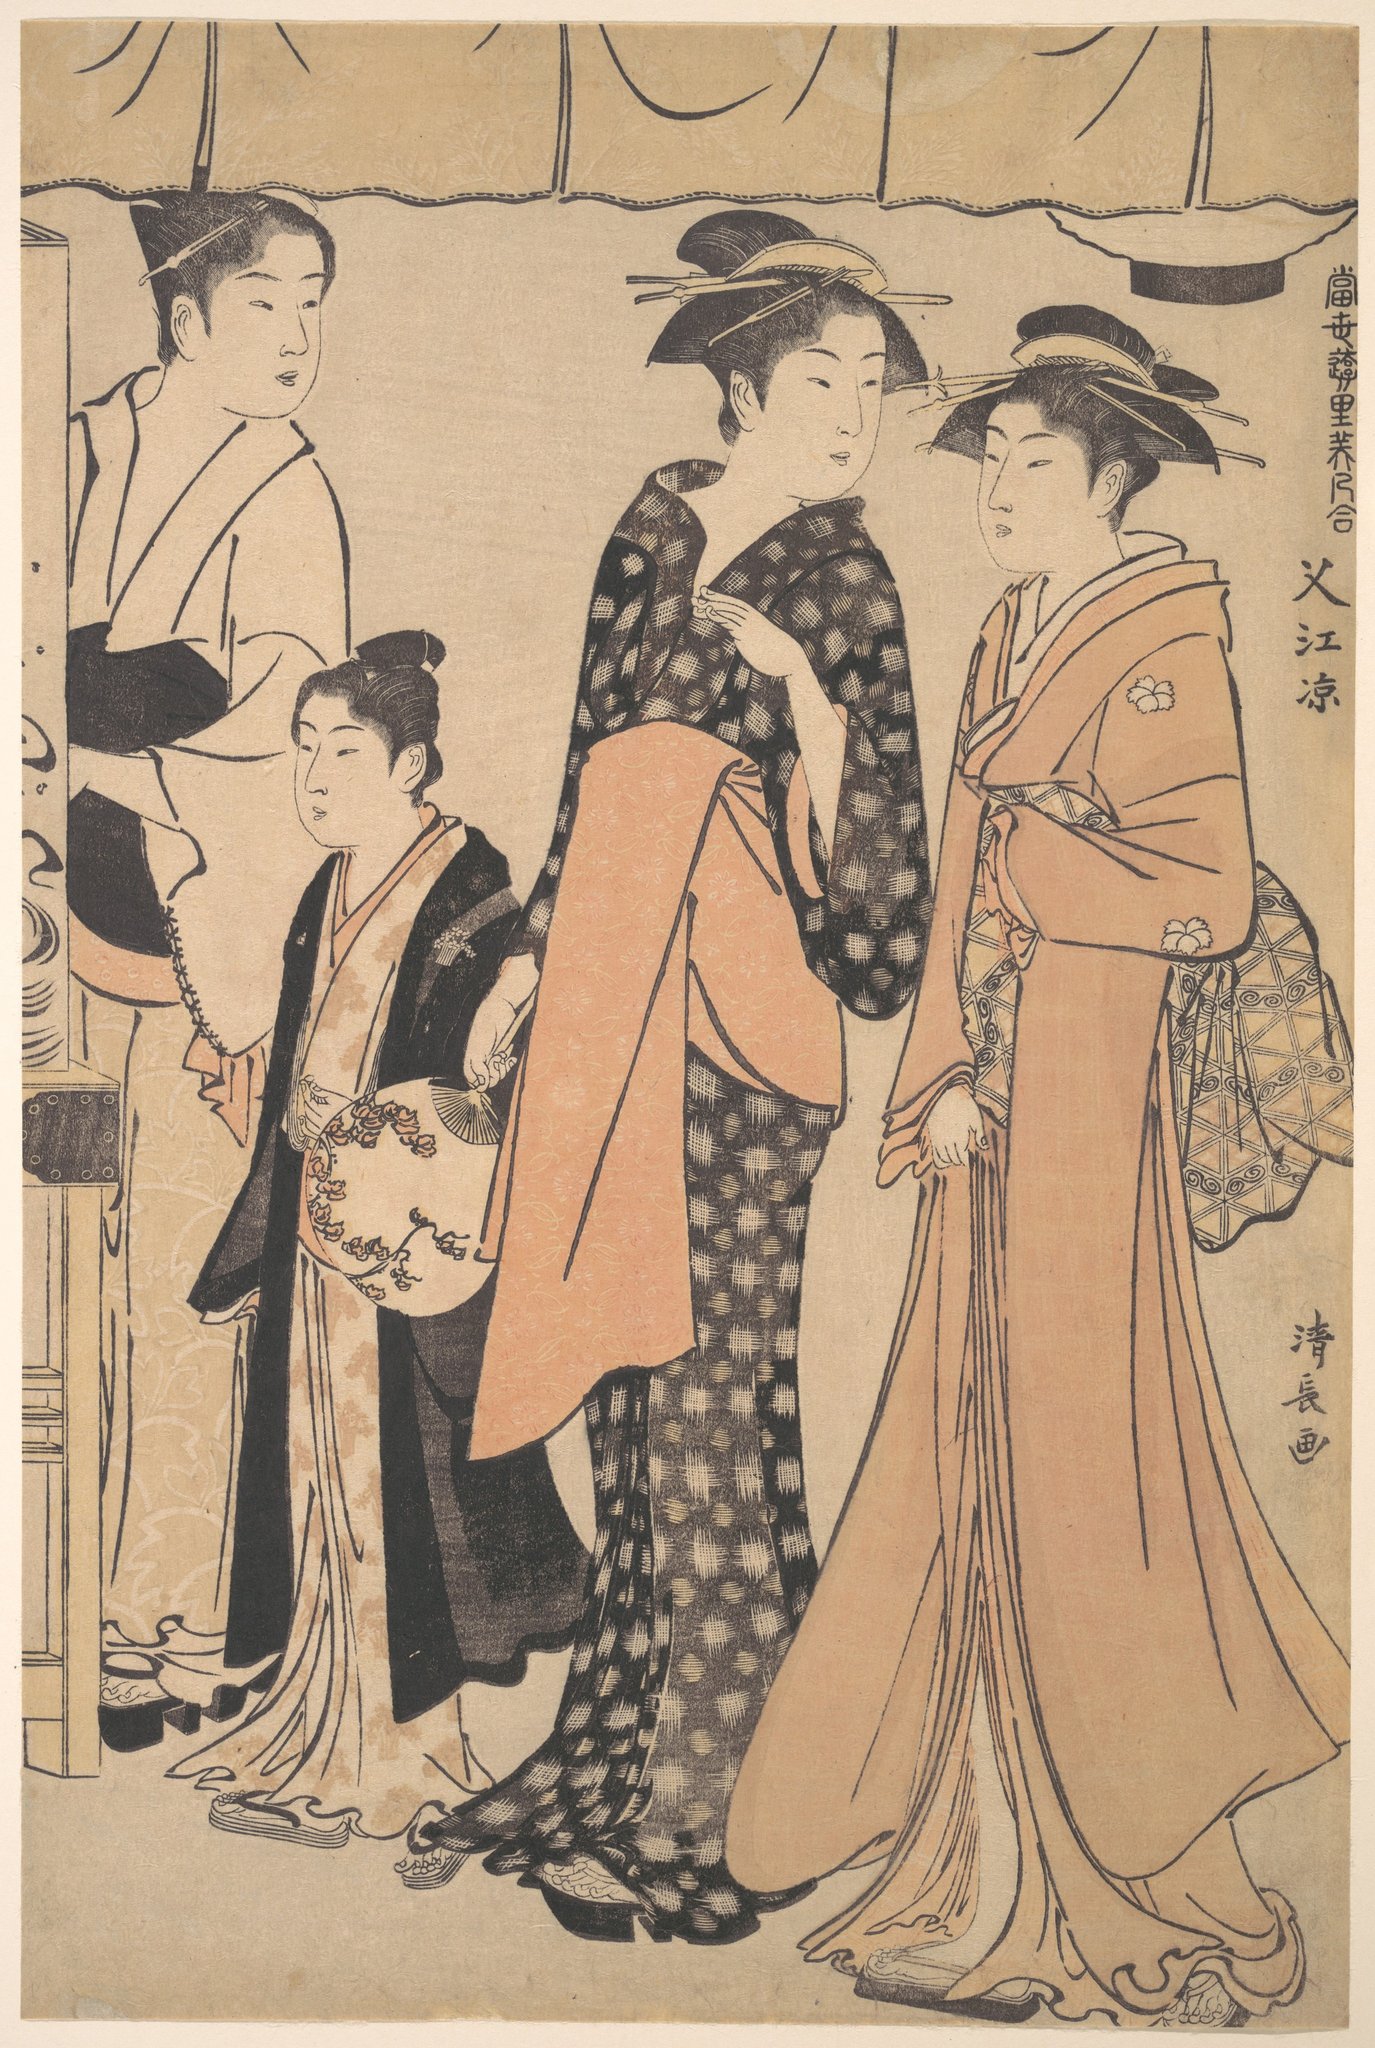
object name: print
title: Cooling Off at Nakazu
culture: japanese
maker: torii kiyonaga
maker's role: artist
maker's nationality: japanese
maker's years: 1752-1815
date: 1782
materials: ink, paper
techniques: woodblock print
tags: fans,boys,women